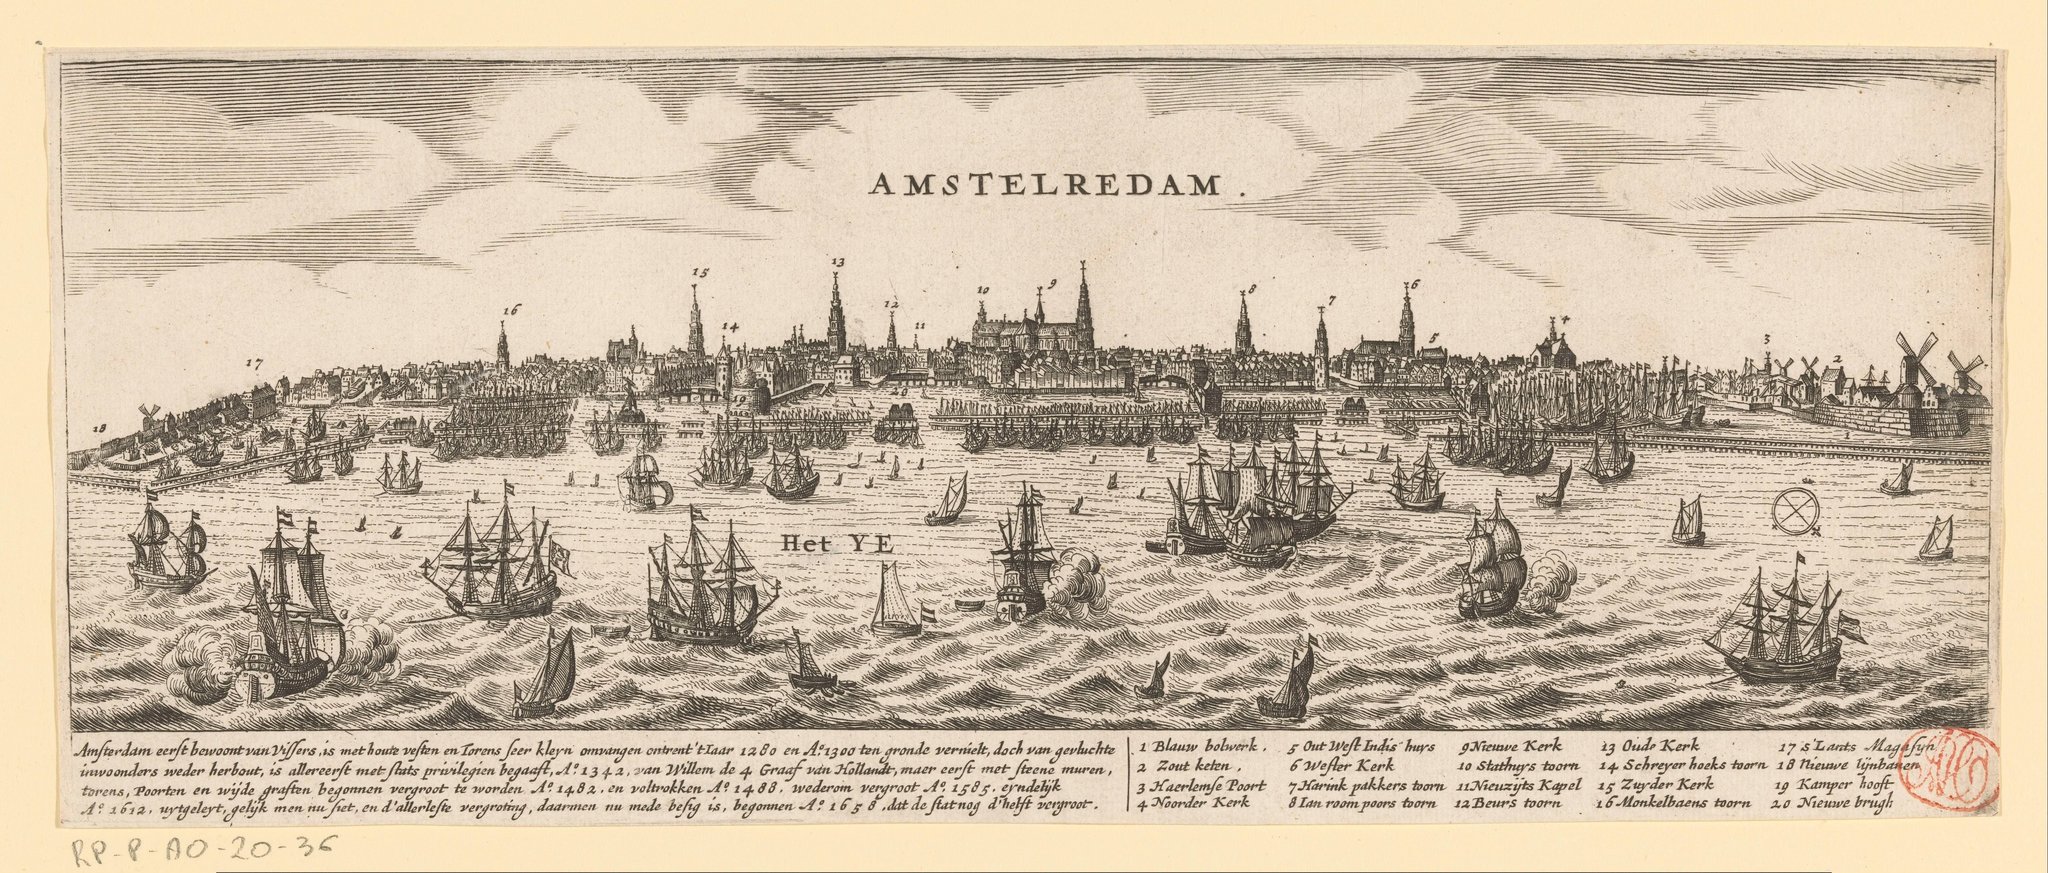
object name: book illustration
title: Amstelredam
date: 1664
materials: paper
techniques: engraving, etching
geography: amsterdam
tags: prospect of city, town panorama, silhouette of city, amsterdam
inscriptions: collector's mark: Lugt 195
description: Huidige staat van prent ook gebruikt in: Fockens, Melchior. Beschrijving Der wijdt-vermaarde Koop-stadt Amstelredam, Van haar eerste beginselen, zedert den Jare 1203. oude Voorrechten, verscheyde Vergrootingenoude Voor-rechten, en verscheyde Vergrootingen (…). 3e druk. Amsterdam: Marcus Willemsz. Doornick, 1664. En in: Zesen, Philipp von. Beschrybung der Weidtberuhmde Kauf-Stadt Amstelredam / Beschreibung der Stadt Amsterdam darinnen von derselben ersten ursprunge bis auf gegenwartigen zustand (…). Amsterdam: Marcus Willemsz. Doornick, 1664. En in de eerste geillustrreder editie van J. de Parival: 'Les delices de la Hollande'. Amsterdam, 1669. Eerdere staat van prent (rechtsboven genummerd: 51) ook gebruikt in: Fockens, Melchior. Beschrijvinge Der wijdt-vermaarde Koop-stadt Amstelredam, Van hare eerste beginselen, oude Voor-rechten, en verscheyde Vergrootingen (…). 1e druk. Amsterdam: Marcus Willemsz. Doornick, 1662. En in: Fockens, Melchior. Beschrijvinge Der wijdt-vermaarde Koop-stadt Amstelredam, Van hare eerste beginselen, oude Voor-rechten, en verscheyde Vergrootingen (…). 2e druk. Amsterdam: Marcus Willemsz. Doornick, 1662. Voor latere staat (rechtsboven genummerd: 6) zie: RP-P-AO-20-41.